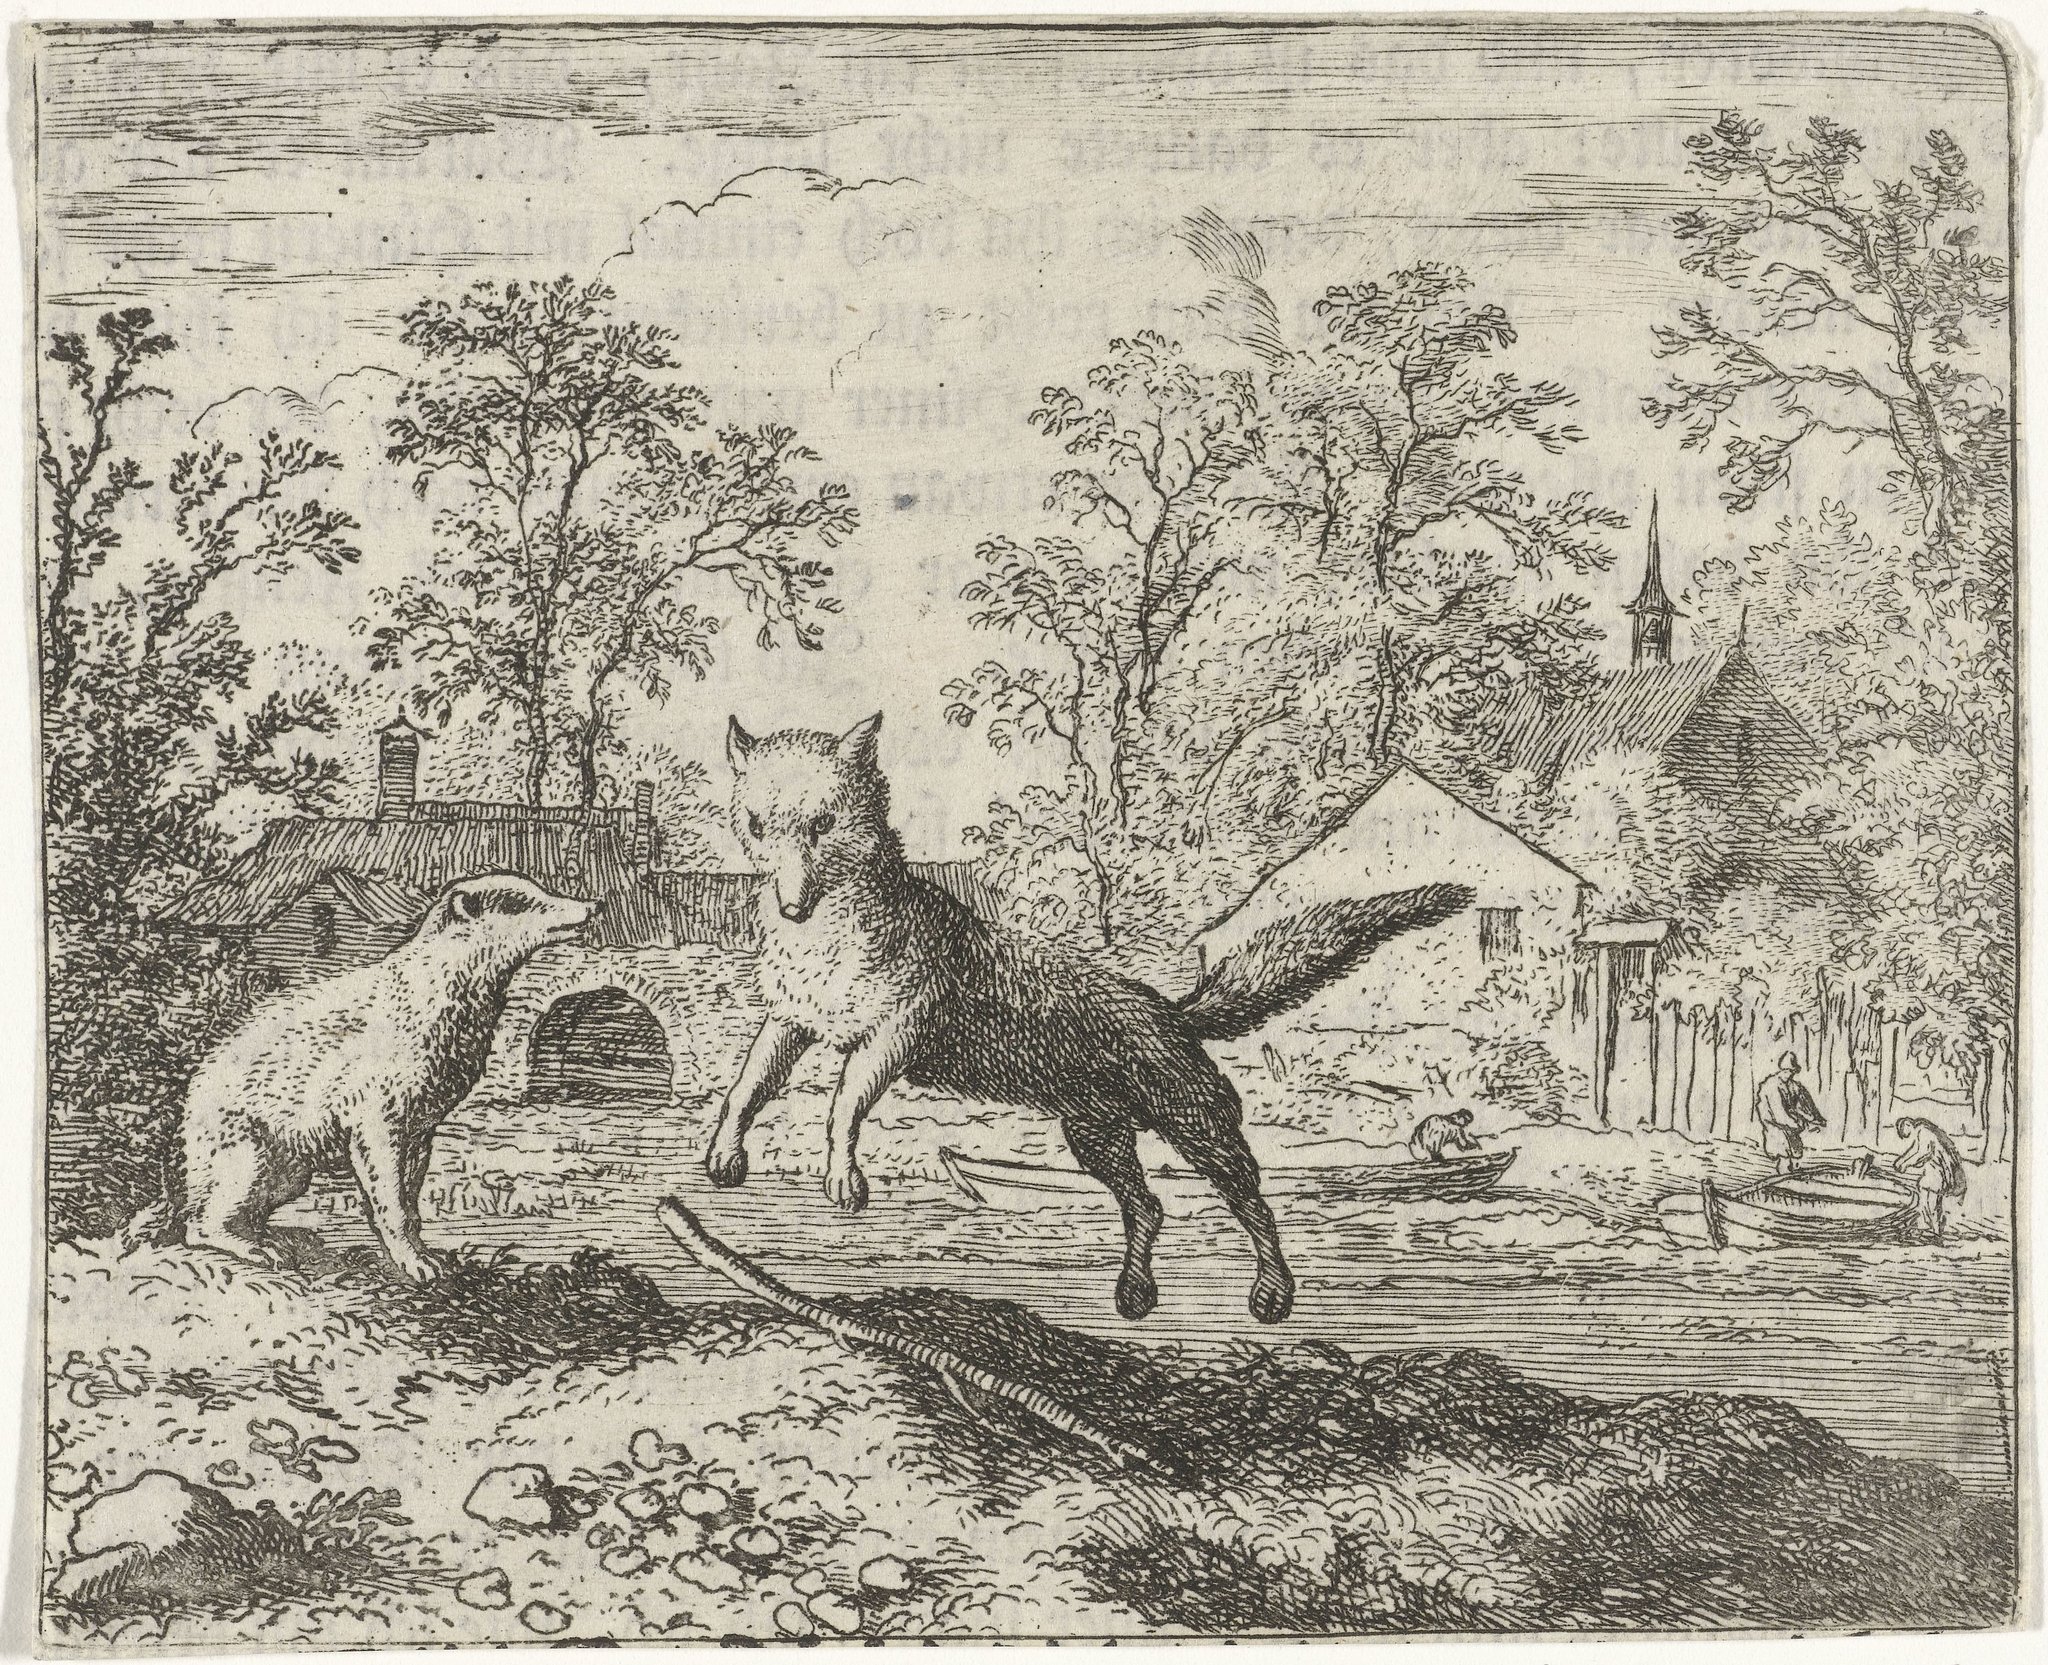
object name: book illustration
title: Reinaert de vos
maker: allaert van everdingen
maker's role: draughtsman, painter, print maker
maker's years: 1621-1675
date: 1665-1675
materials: paper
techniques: etching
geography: netherlands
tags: fable of reynard the fox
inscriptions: collector's mark: Lugt 2228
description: Reinaert de vos en Grinbeert de das aan de oever van een rivier. Op de achtergrond een dorp en drie personen bij roeiboten. Op de achterkant van de prent een Duits tekstfragment uit het verhaal van Reinaert de vos.